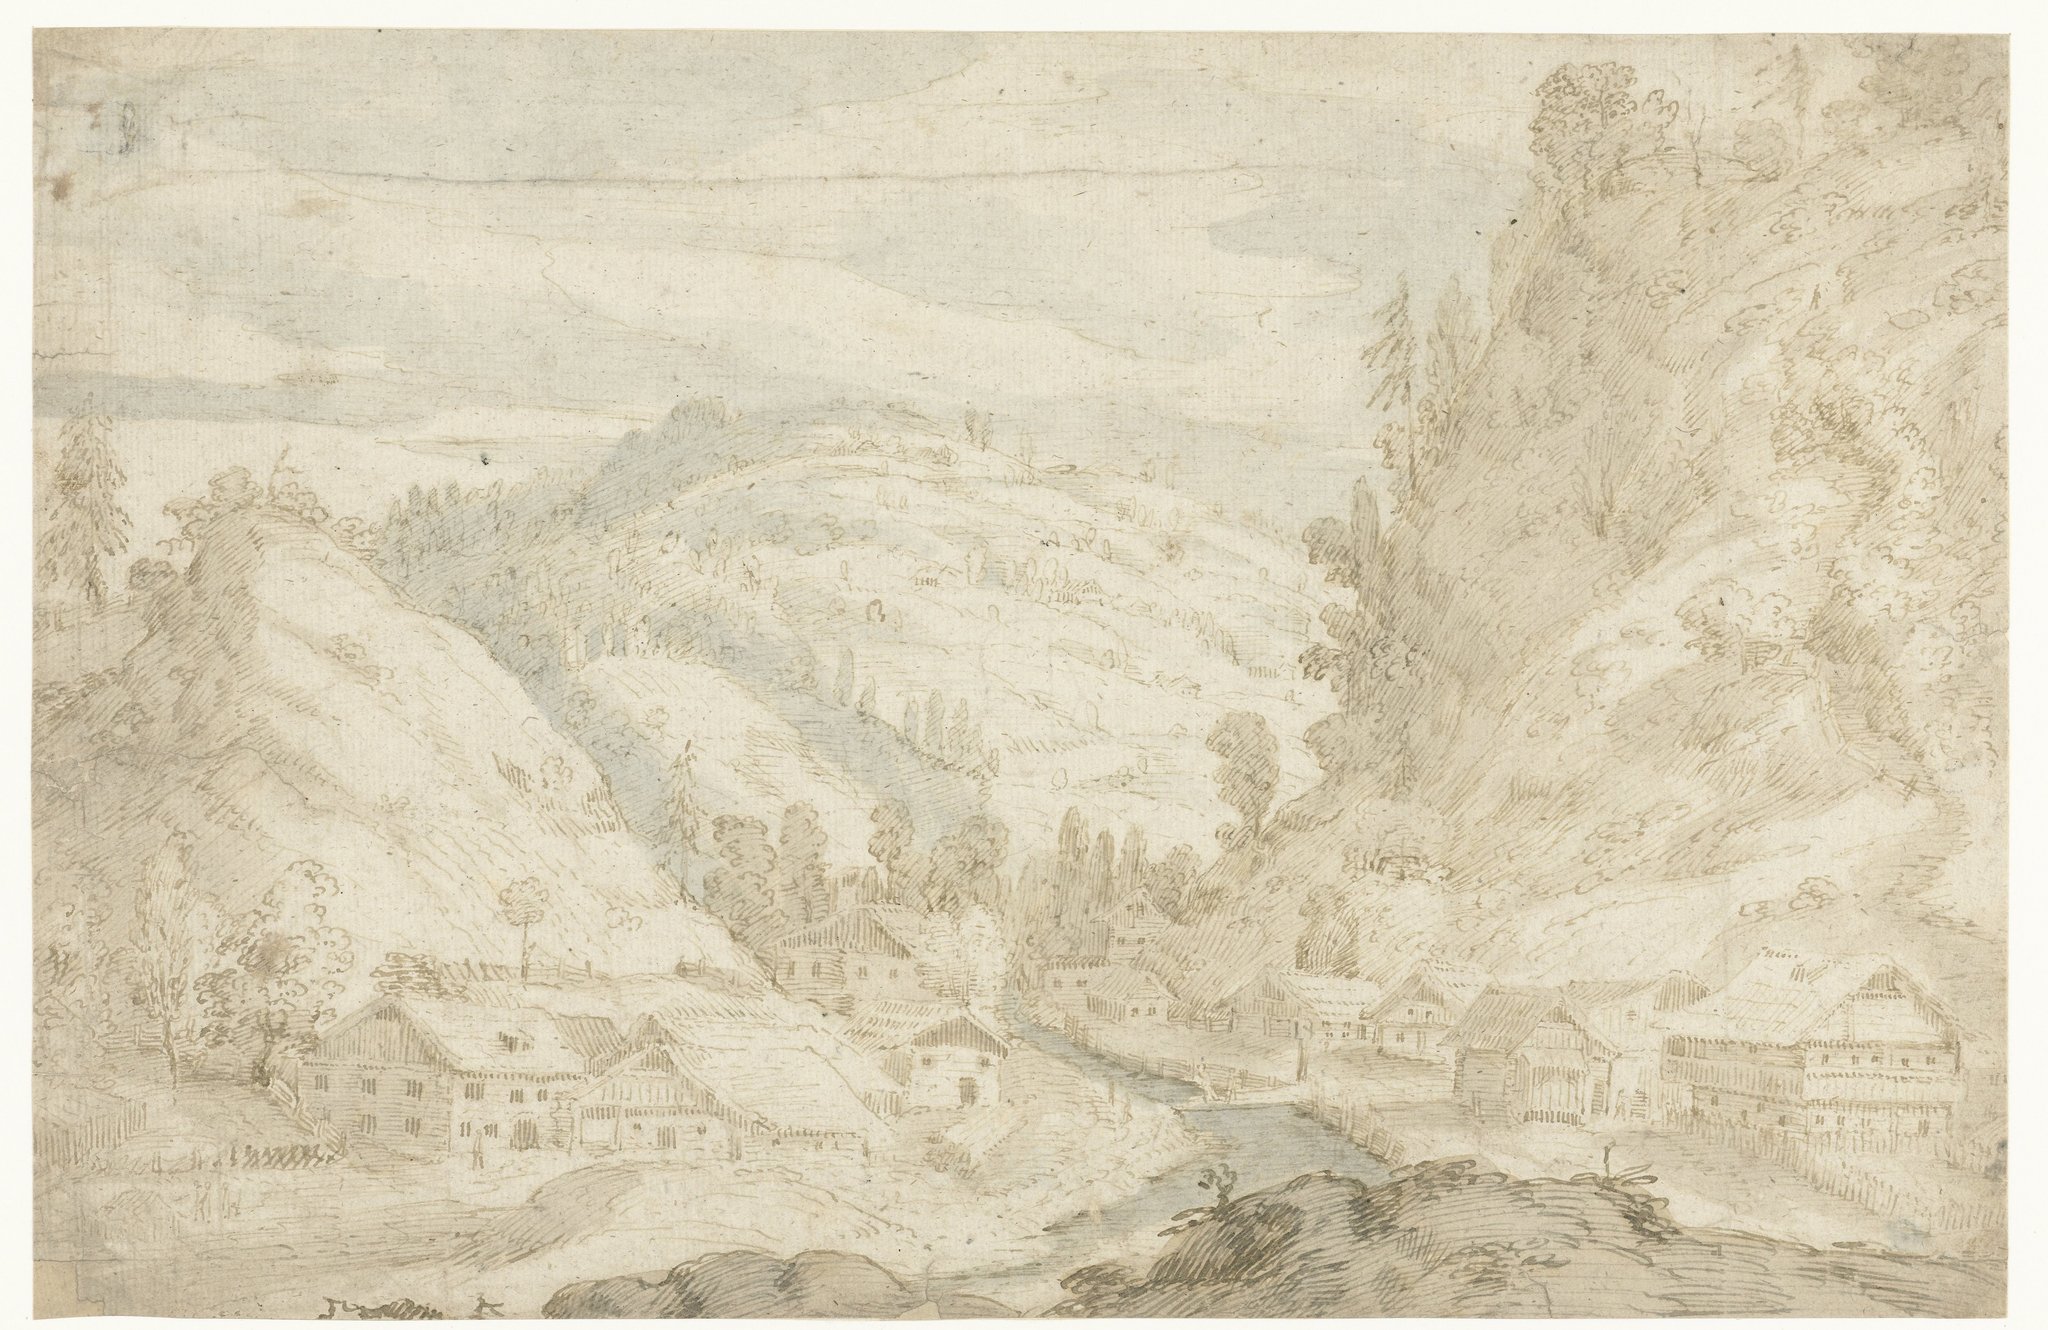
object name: drawing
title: Gezicht op een dal met een dorp en een bergbeekje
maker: frederik van valckenborch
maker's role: draughtsman, painter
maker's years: 1566-1623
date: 1598-1599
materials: ink, paper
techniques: brush, pen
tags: forest, wood, mountains